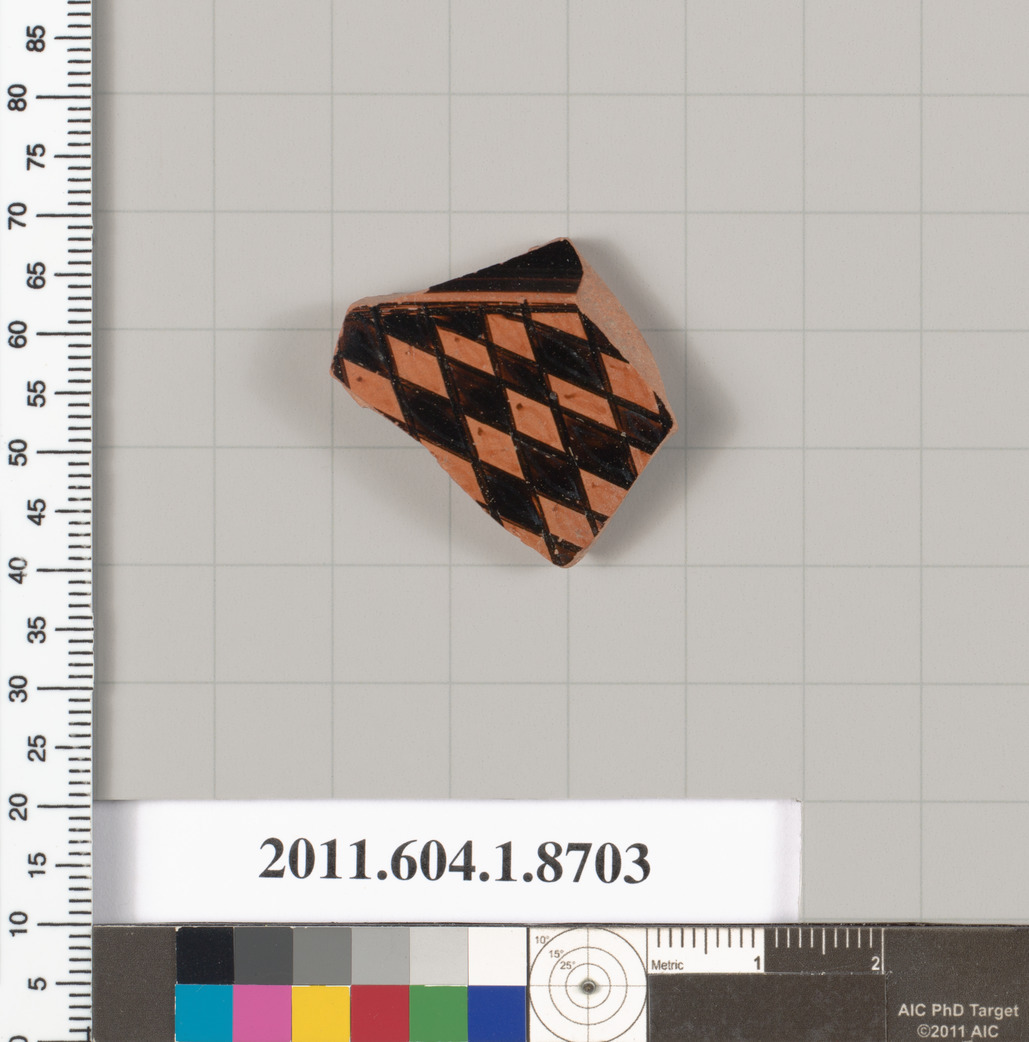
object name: kylix fragment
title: Terracotta fragment of a stemless kylix (drinking cup)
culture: greek, attic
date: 430-420 BCE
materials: terracotta